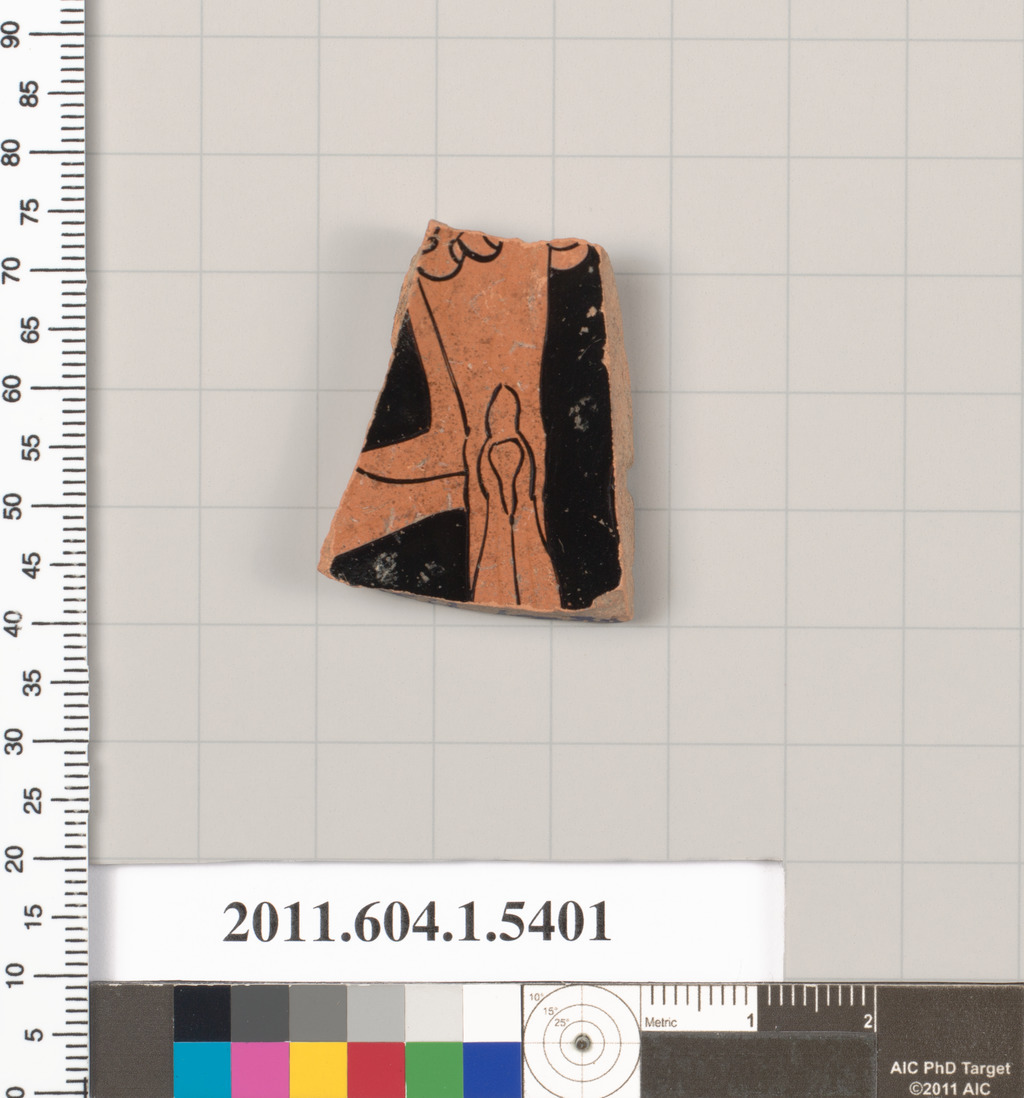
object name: kylix fragment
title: Terracotta fragment of a kylix (drinking cup)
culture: greek, attic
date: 490-480 BCE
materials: terracotta